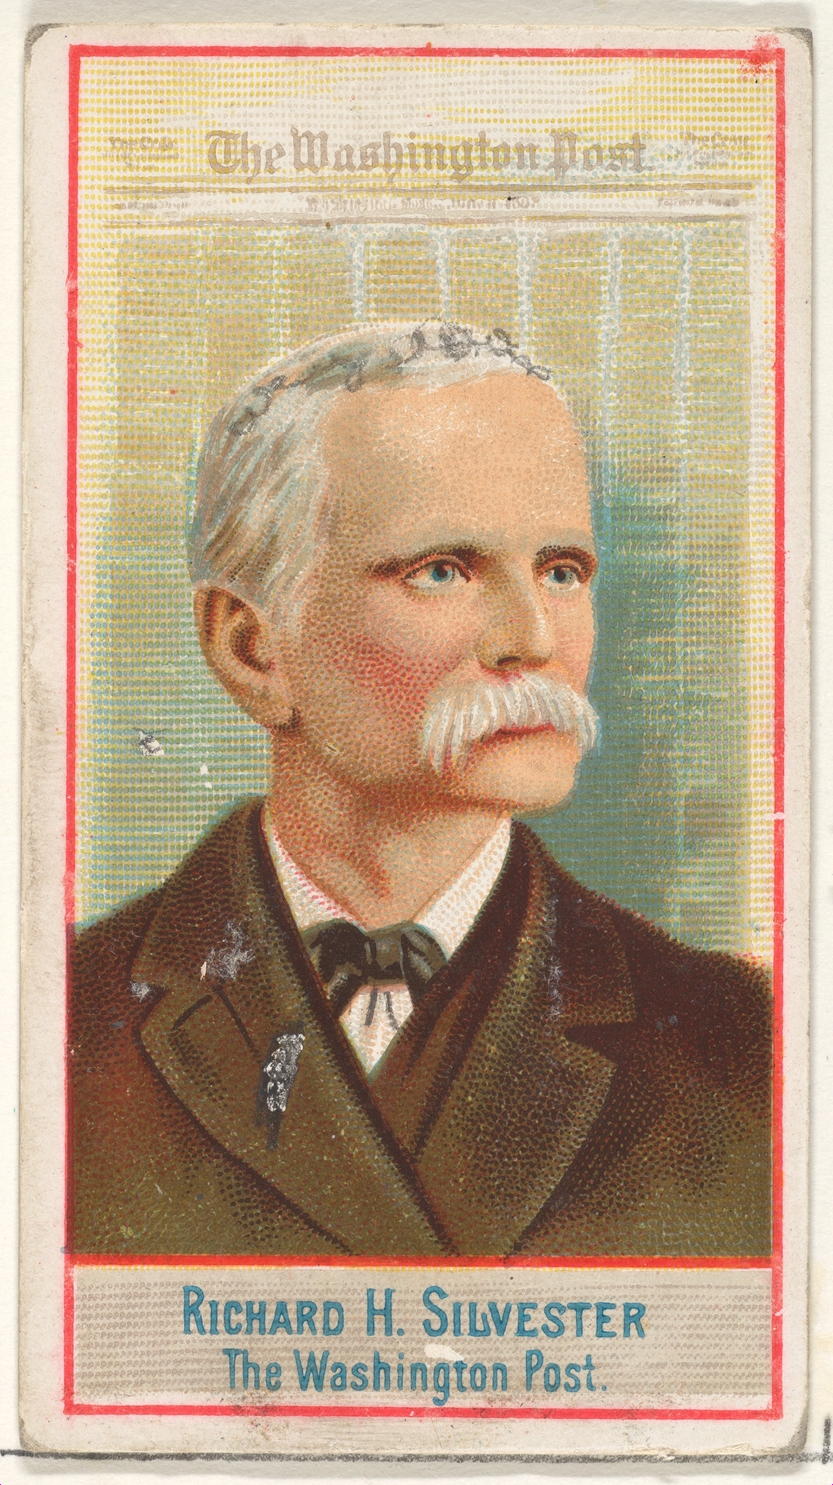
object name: print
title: Richard H. Silvester, The Washington Post, from the American Editors series (N1) for Allen & Ginter Cigarettes Brands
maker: allen & ginter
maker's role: publisher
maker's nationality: american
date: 1887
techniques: color lithograph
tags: men,portraits